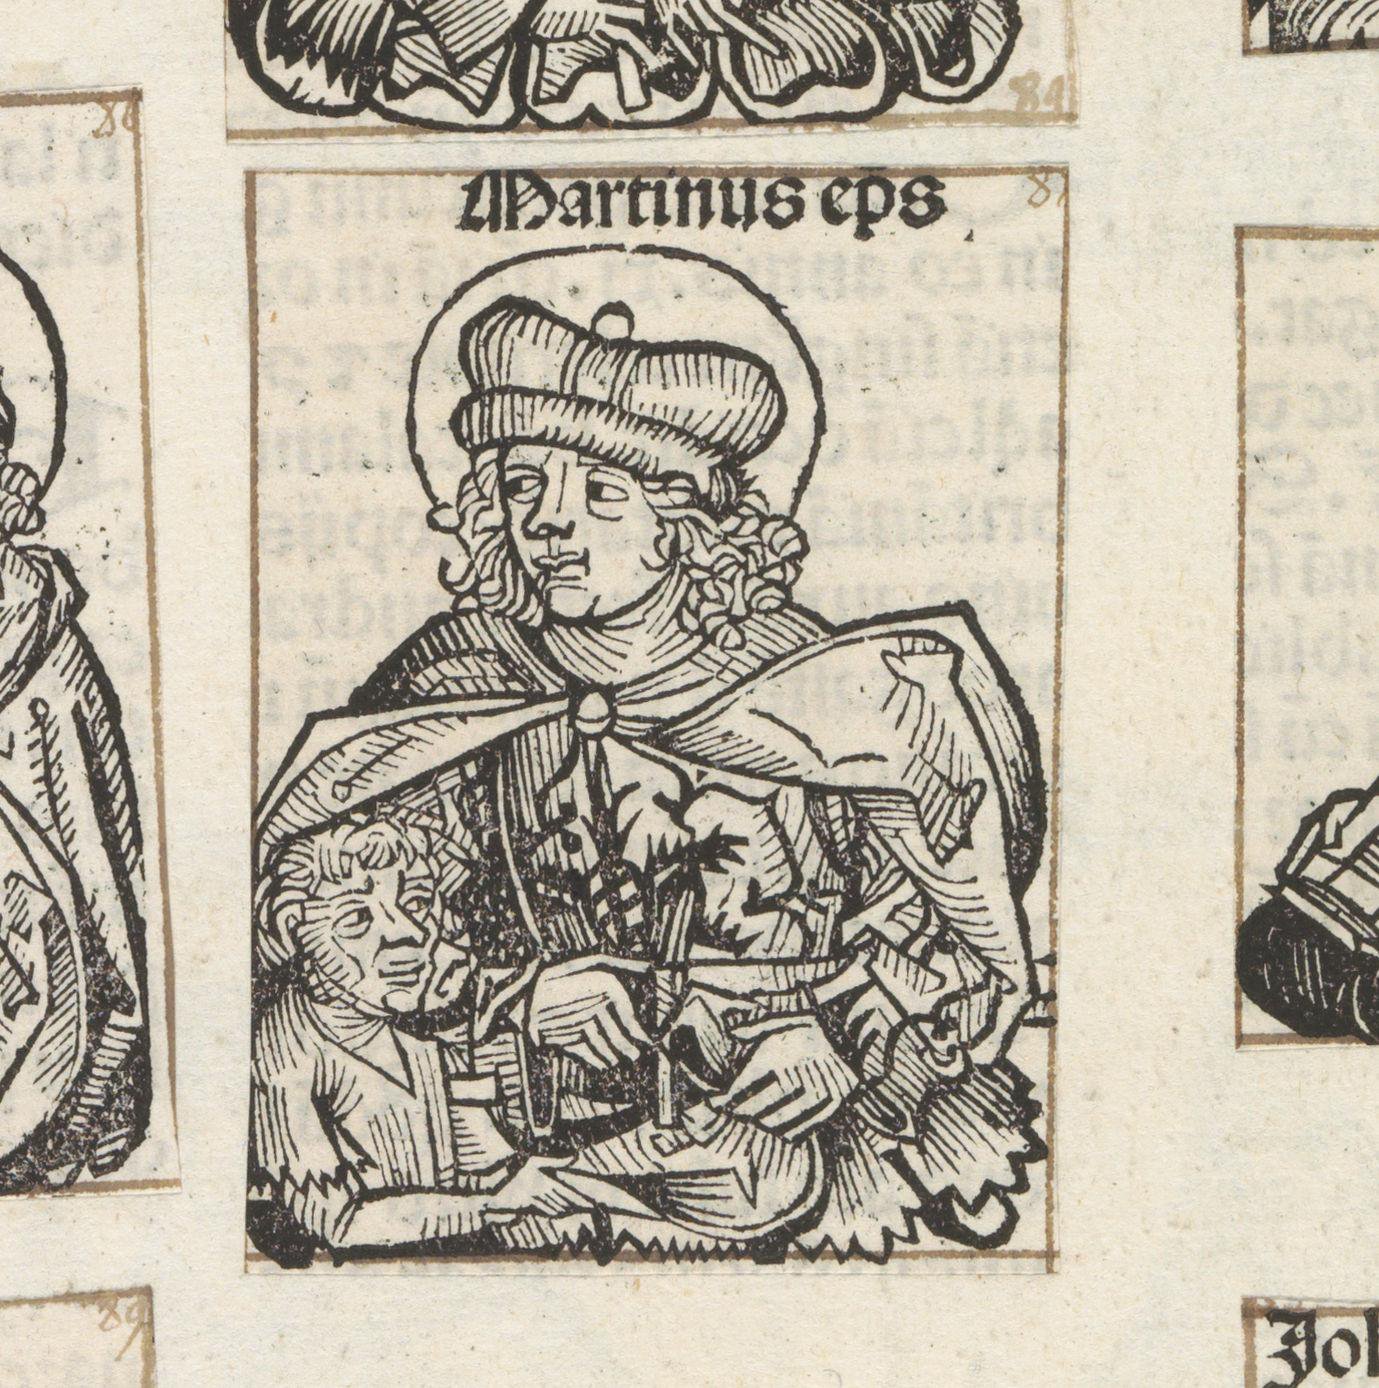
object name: print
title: Liber Chronicarum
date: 1493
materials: paper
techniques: letterpress printing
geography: nuremberg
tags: martin(us), bishop of tours; possible attributes: beggar, goose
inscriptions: inscription: ‘87’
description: De houtsnede wordt gebruikt als boekillustratie in de Liber Chronicarum (of Neurenbergkroniek) van Hartmann Schedel, verschenen in het Latijn en Duits in 1493. Zie de Latijnse uitgave, folio 134v.